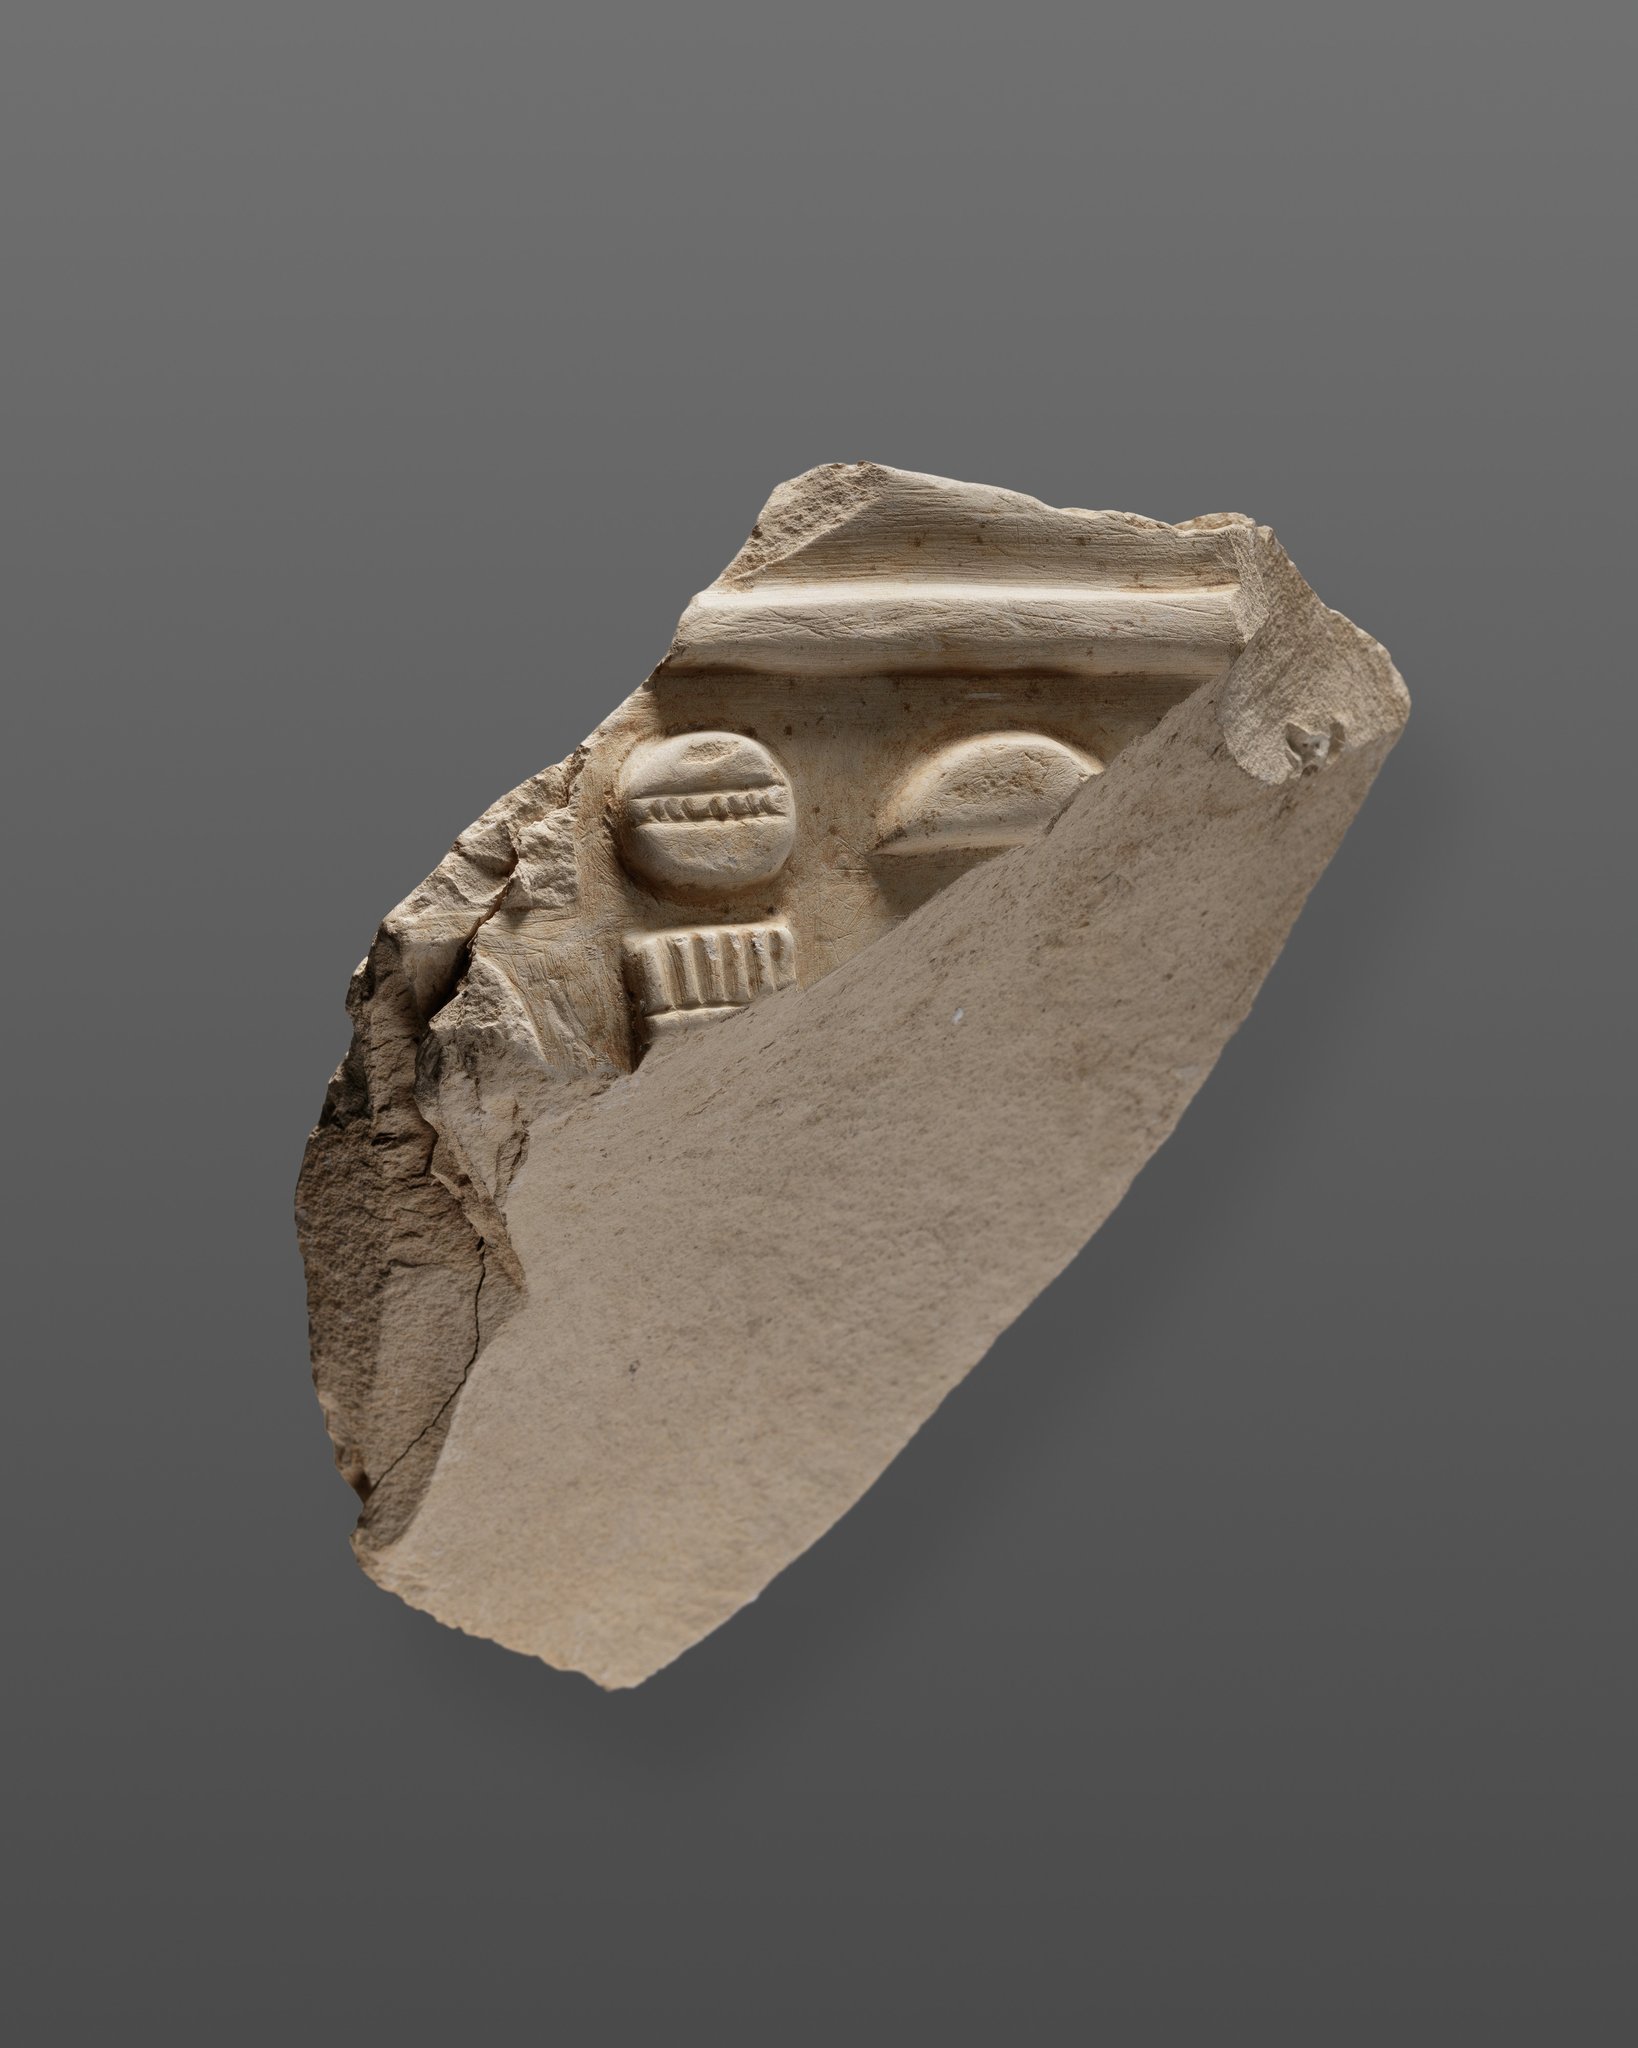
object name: relief fragment 41, tomb of mereri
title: Relief fragment possibly from the tomb of Mereri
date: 2100-2090 BCE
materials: limestone